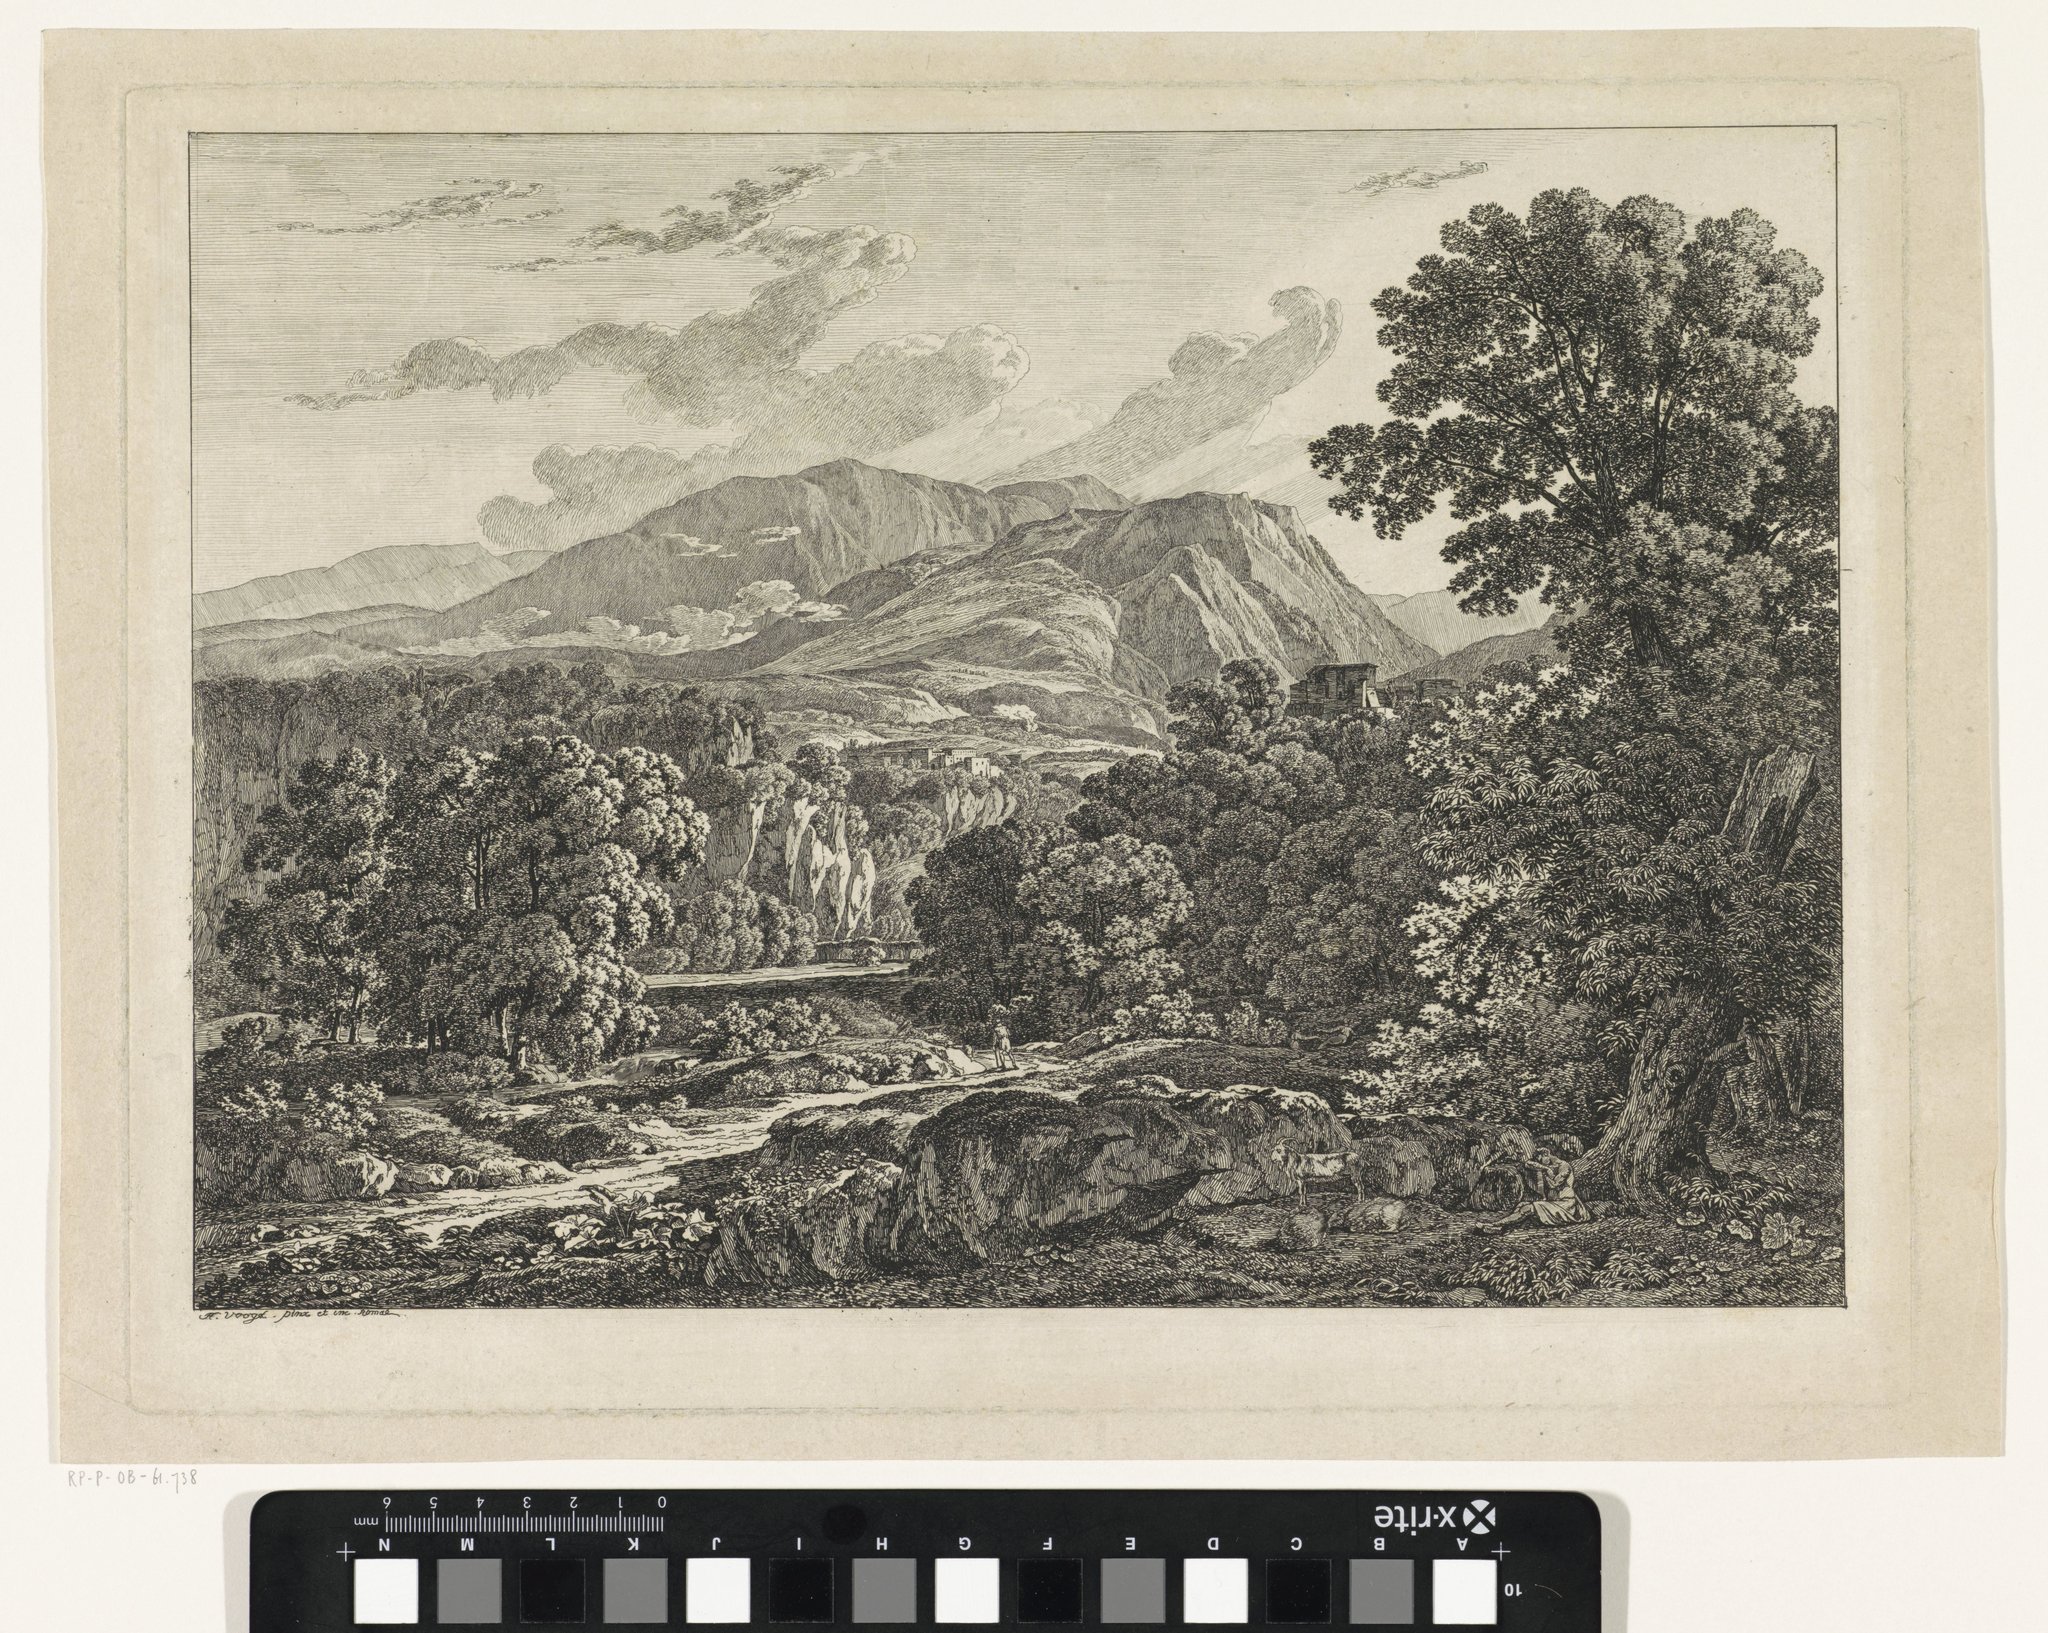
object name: print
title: Bomenrijk berglandschap met rustende herder bij vee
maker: hendrik voogd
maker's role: draughtsman, painter, print maker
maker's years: 1768-1839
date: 1788-1839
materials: paper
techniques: etching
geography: rome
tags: herding, herdsman, herdswoman, shepherd, shepherdess, cowherd, etc., pastorals, arcadian scenes, mountains - hh - ideal landscapes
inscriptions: collector's mark: Lugt 2228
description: Een bomenrijk berglandschap met een rustende herder bij vee. In het midden op een pad een wandelaar.